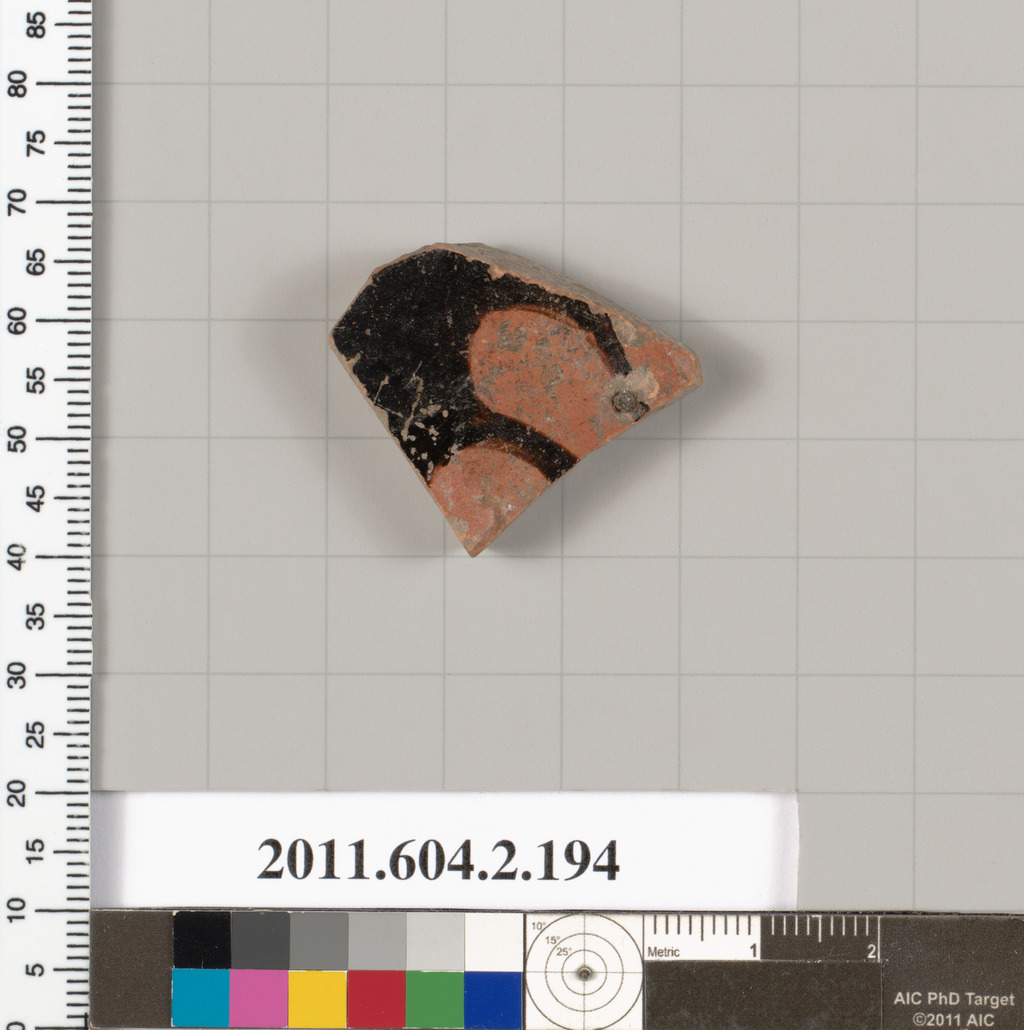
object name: stamnos fragment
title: Terracotta fragment of a stamnos (jar)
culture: greek, attic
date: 500-451 BCE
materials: terracotta